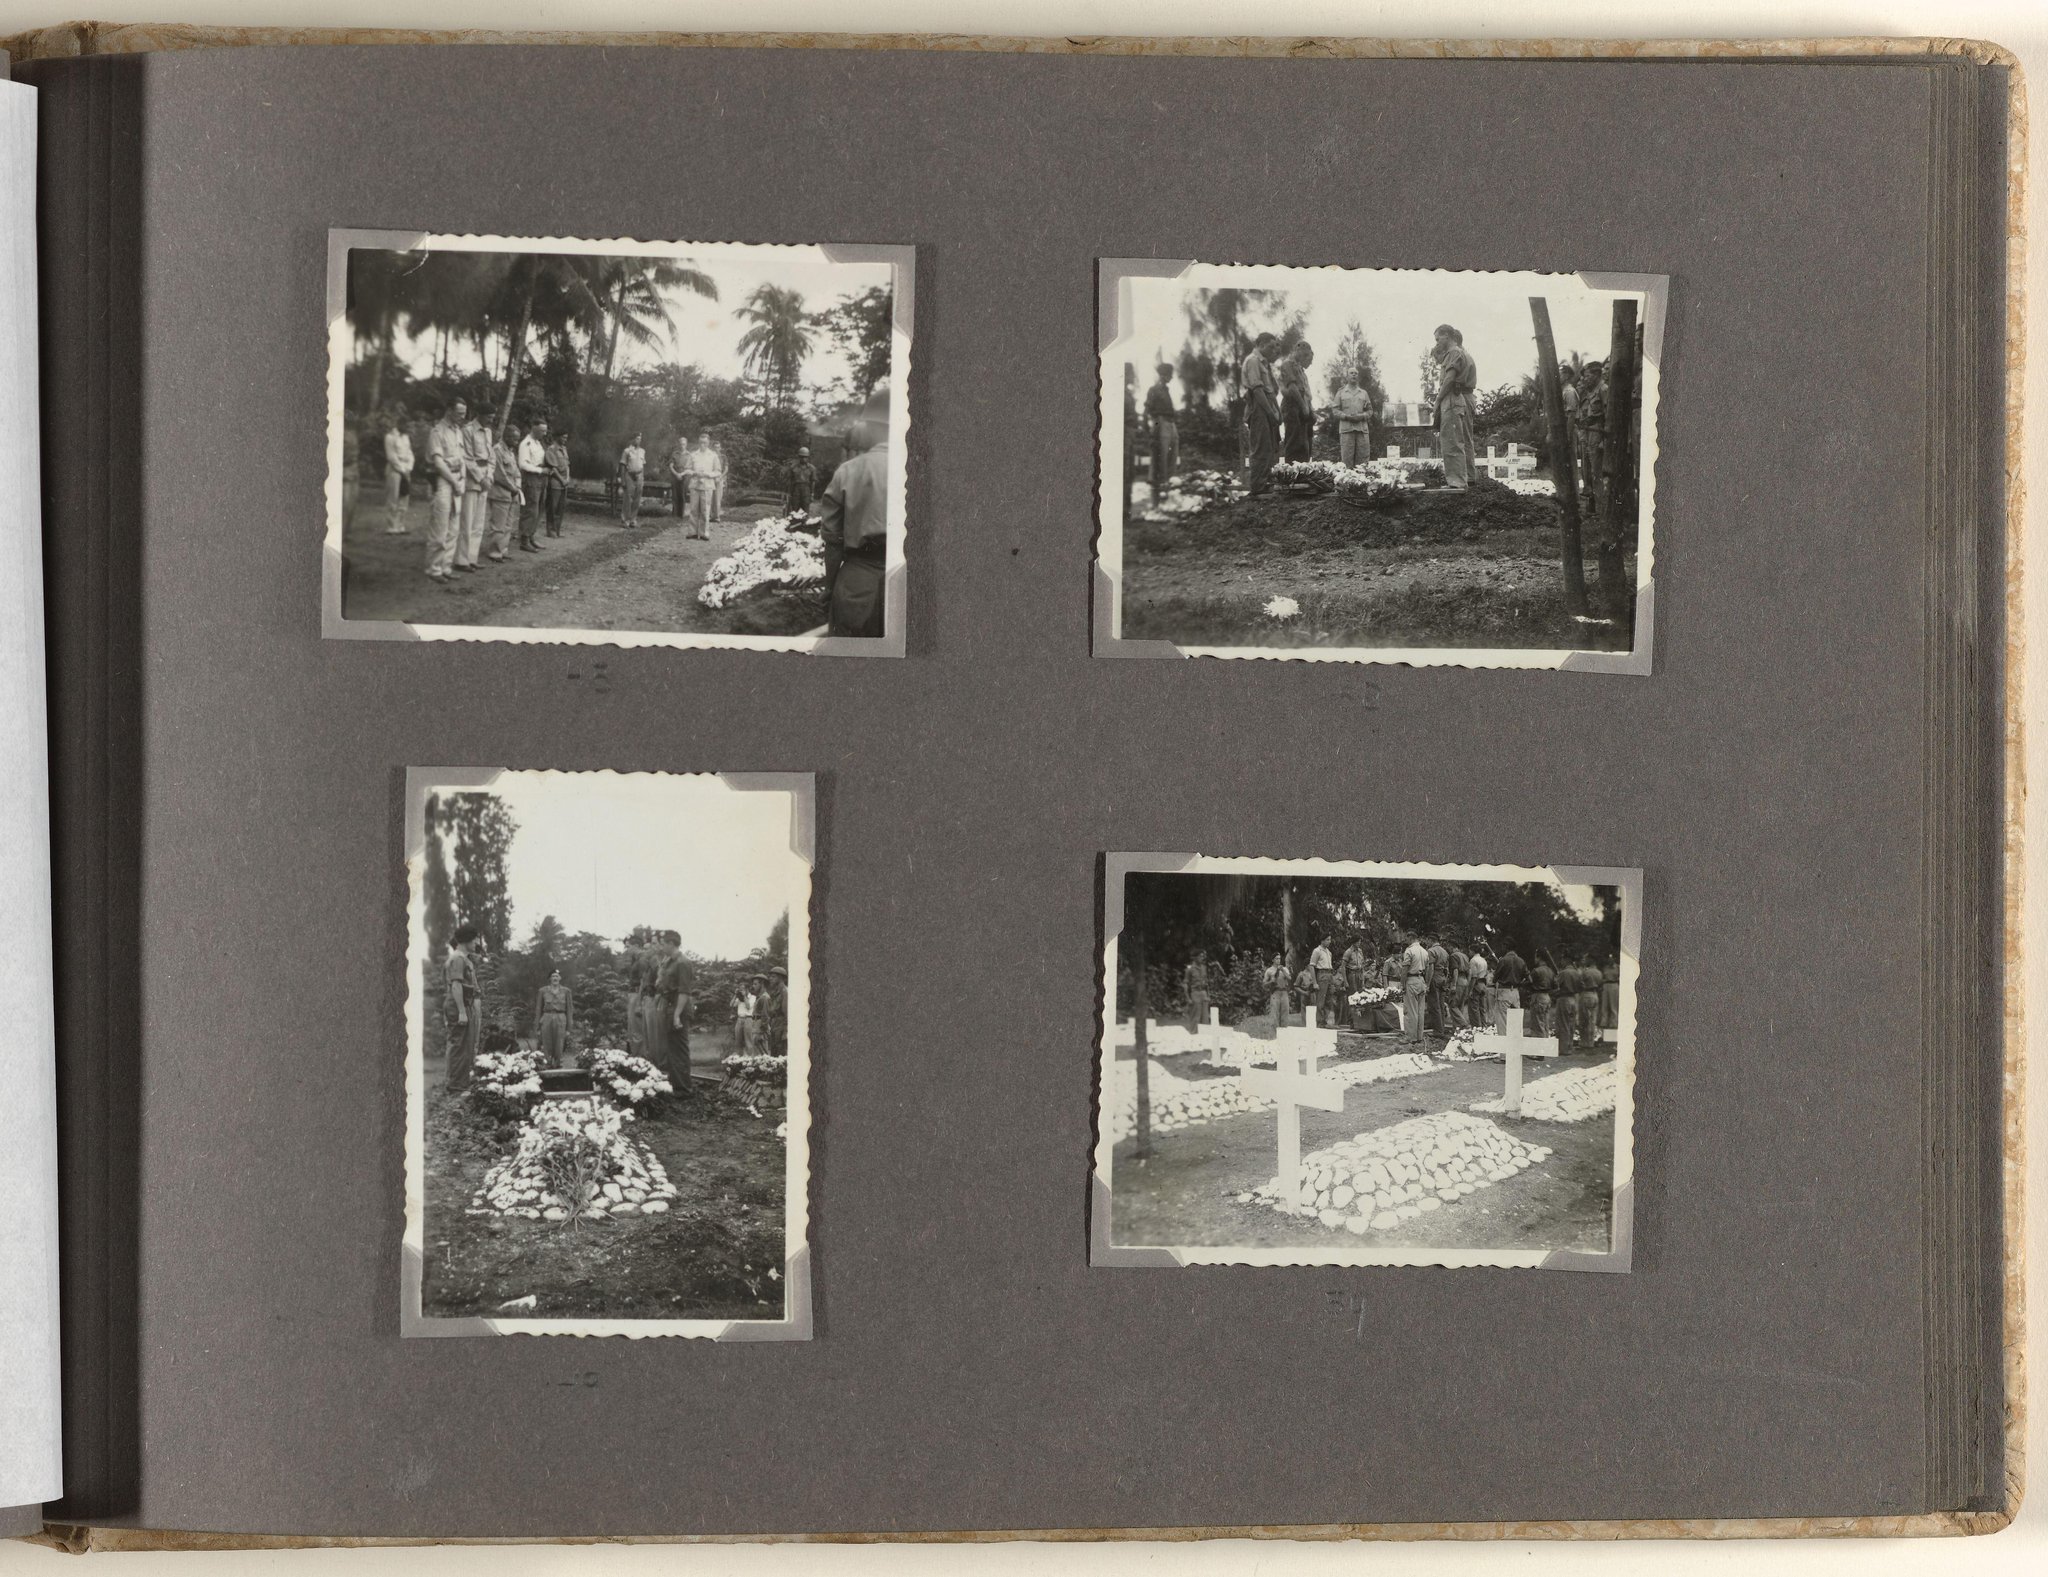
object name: album leaf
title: Begrafenis S. van Barneveld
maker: Anonymous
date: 1949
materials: cardboard, photographic support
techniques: gelatin silver print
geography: dutch east indies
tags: java, colonial system, military service, funerary ceremonial, dutch east indies, the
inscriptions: inscription: ‘Barnevelt.’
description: Albumblad met vier foto's: de begrafenis van Stephen van Barneveld op de Europese begraafplaats te Solo op 7 februari 1949. Onderdeel van het fotoalbum over de diensttijd van Nederlandse militairen in Indië, ca. 1946-1949.